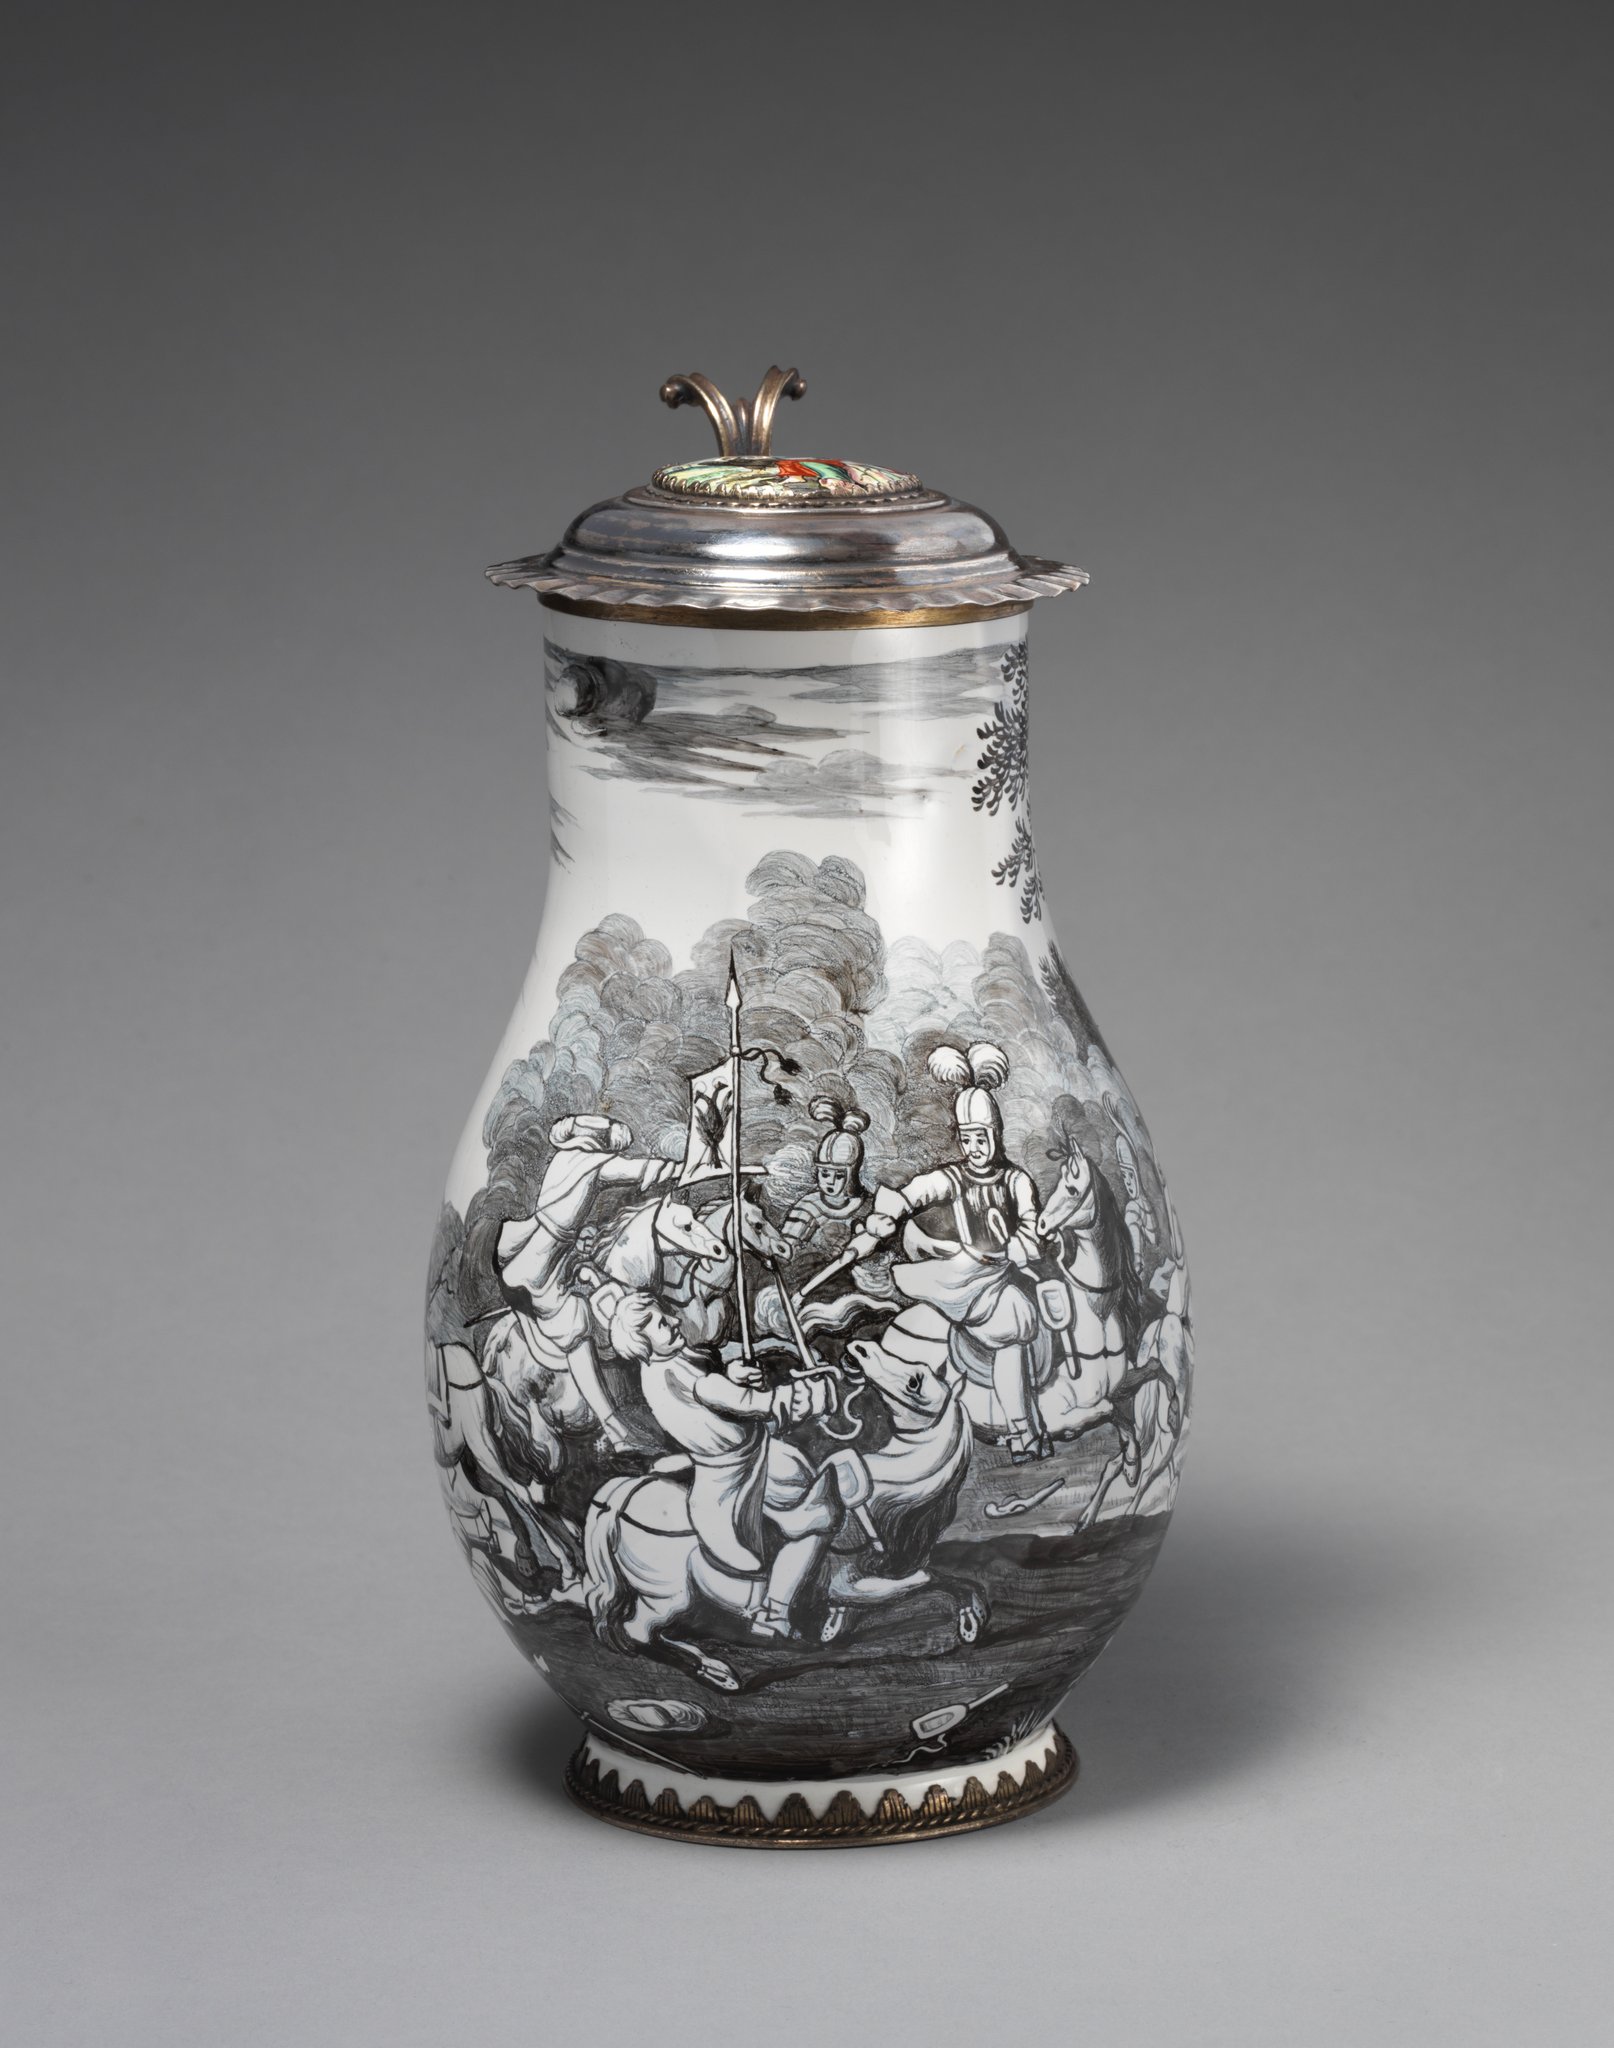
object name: jug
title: Jug with cavalry scene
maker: wölfgang rössler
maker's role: maker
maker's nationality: german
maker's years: 1650-1717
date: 1680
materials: earthenware, gilt silver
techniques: glazing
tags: battles,horses